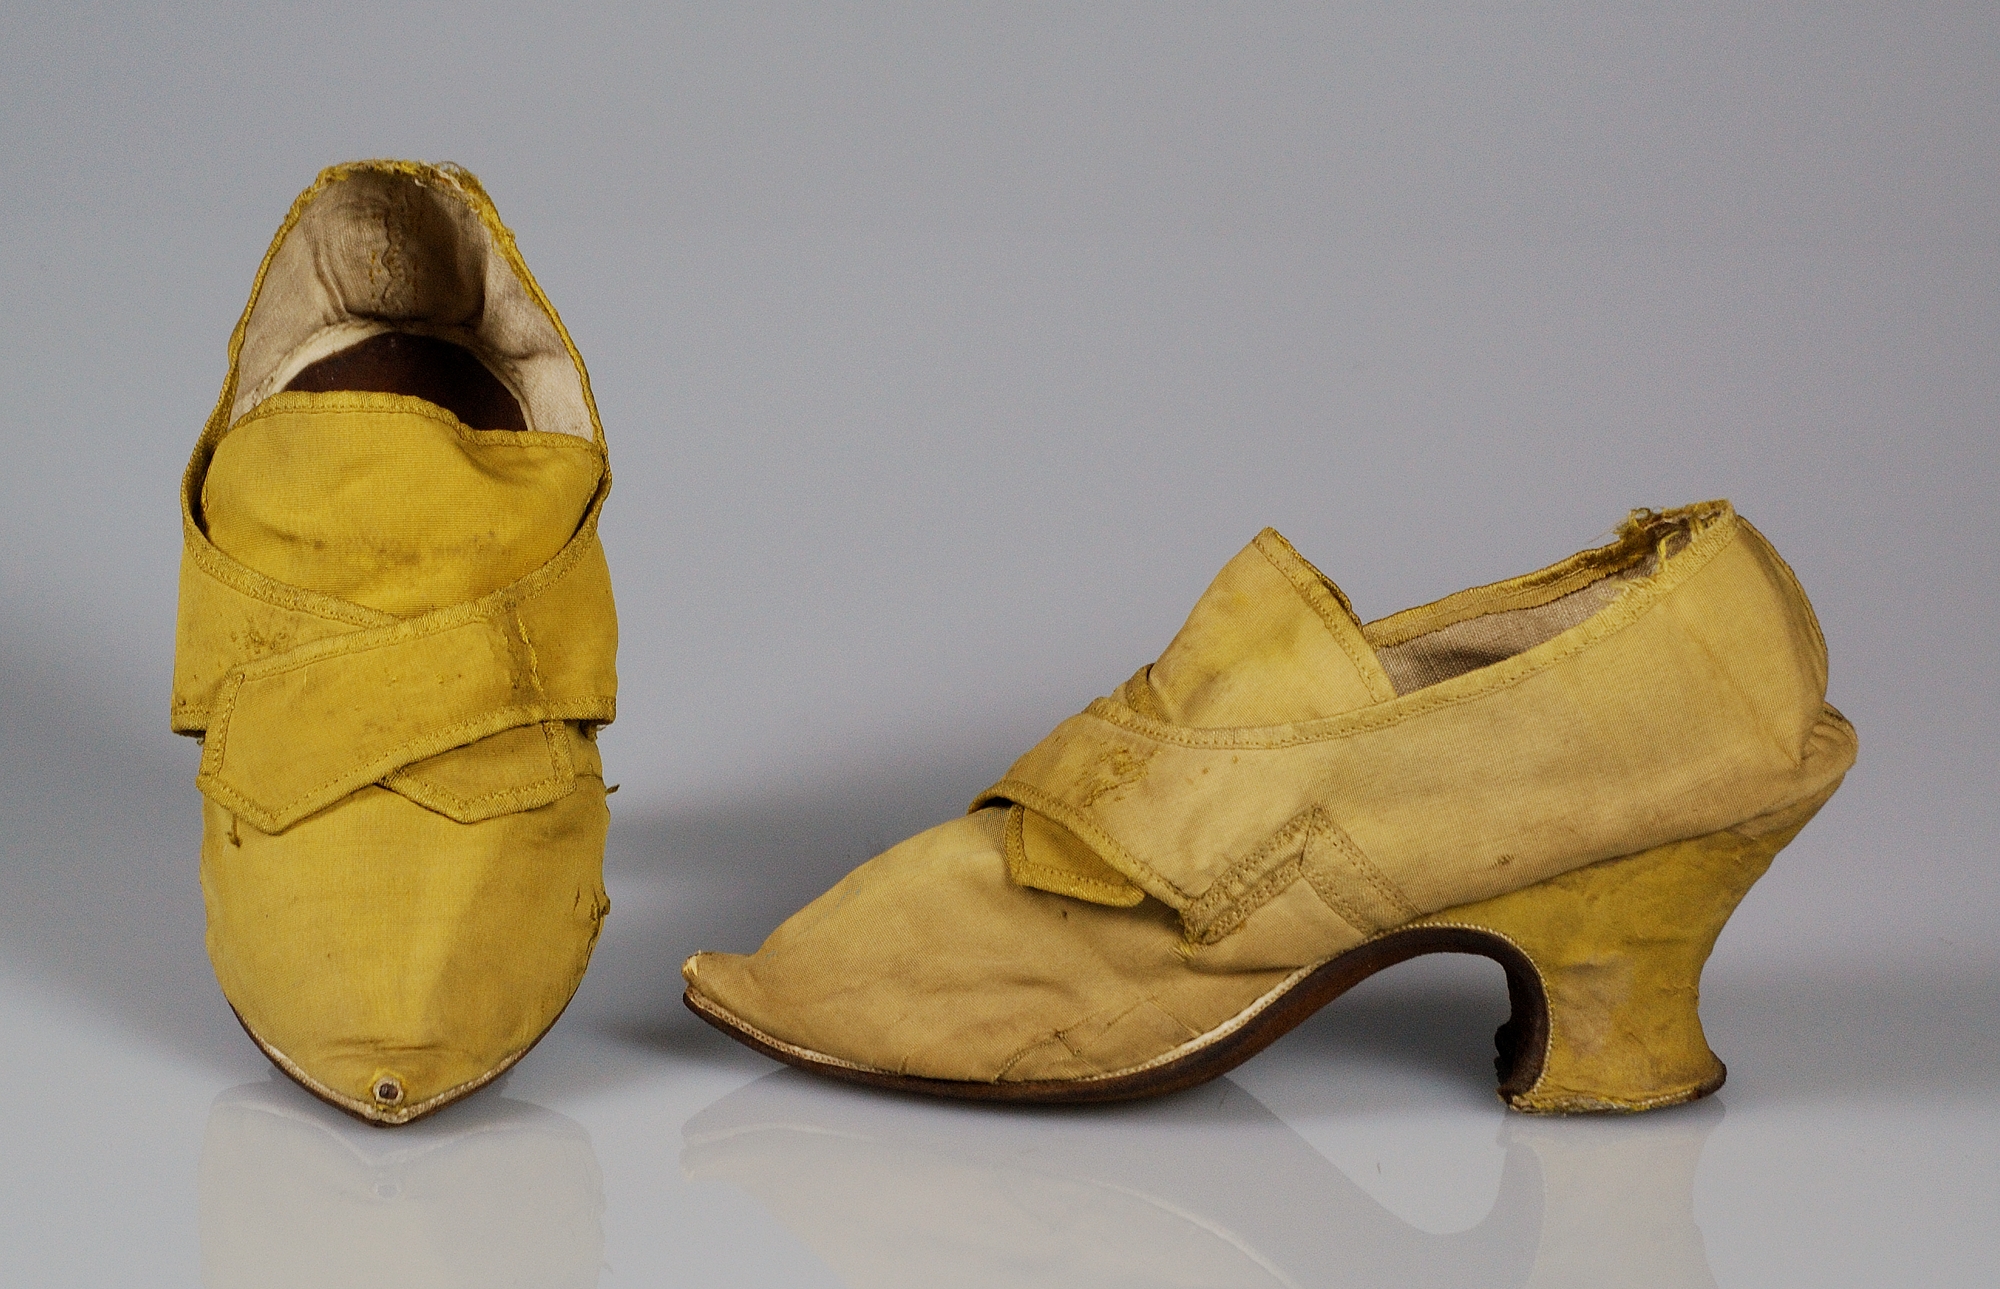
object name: shoe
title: Shoes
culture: european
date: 1730-1759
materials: silk